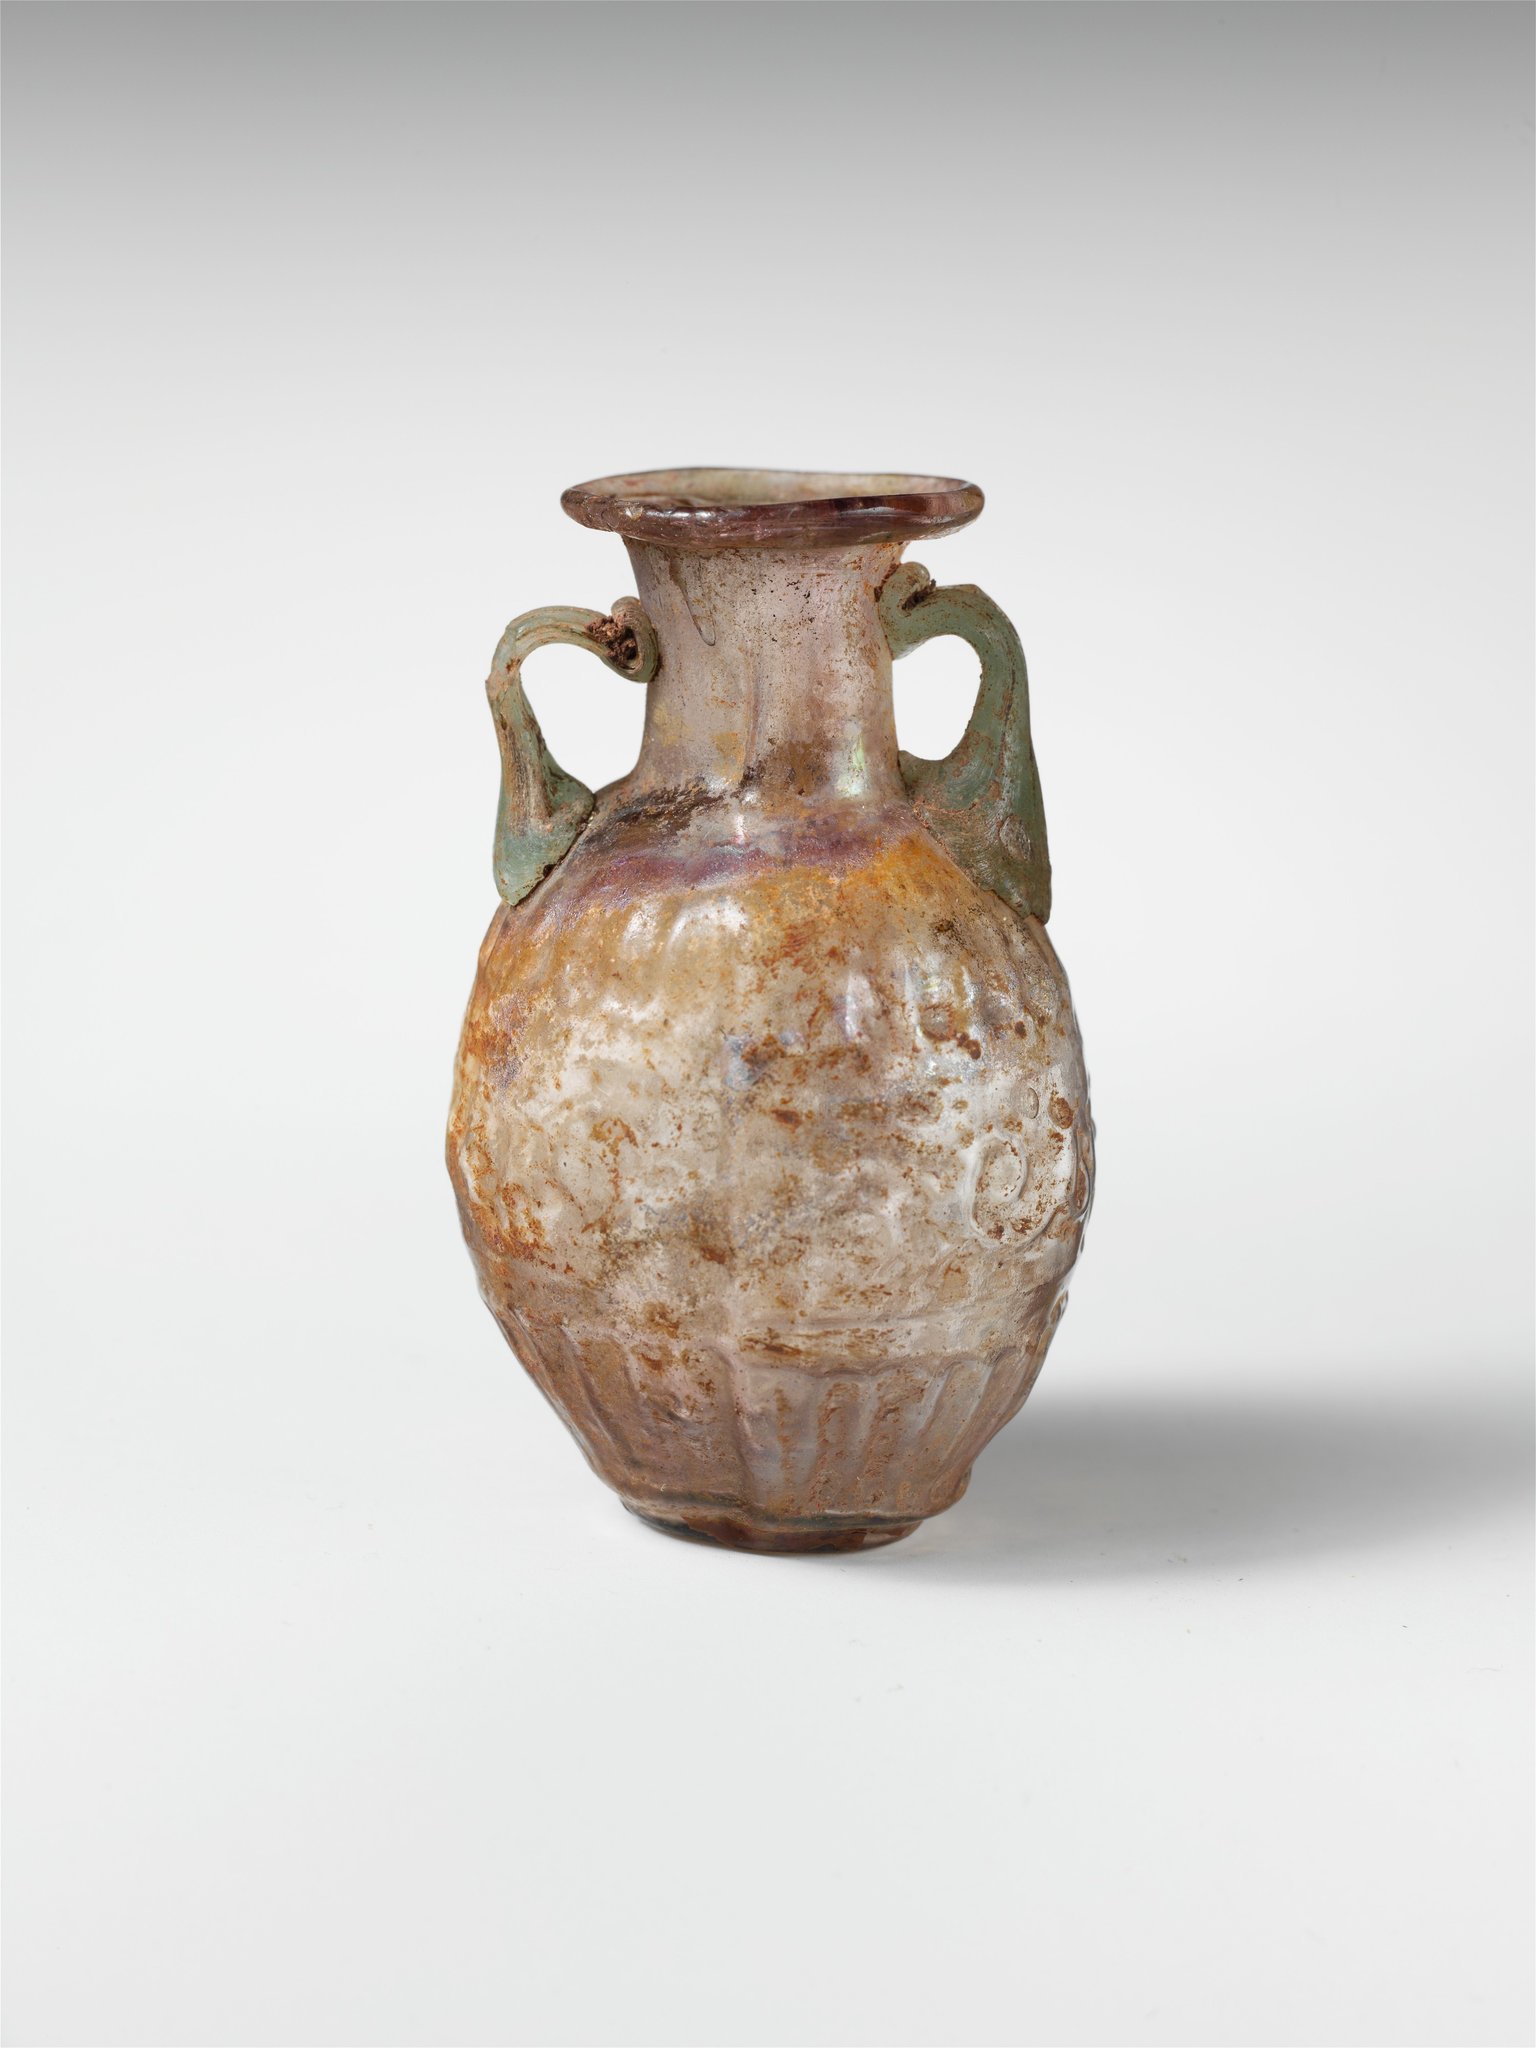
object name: amphoriskos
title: Glass amphoriskos with band of scrolls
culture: roman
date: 1-100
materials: glass